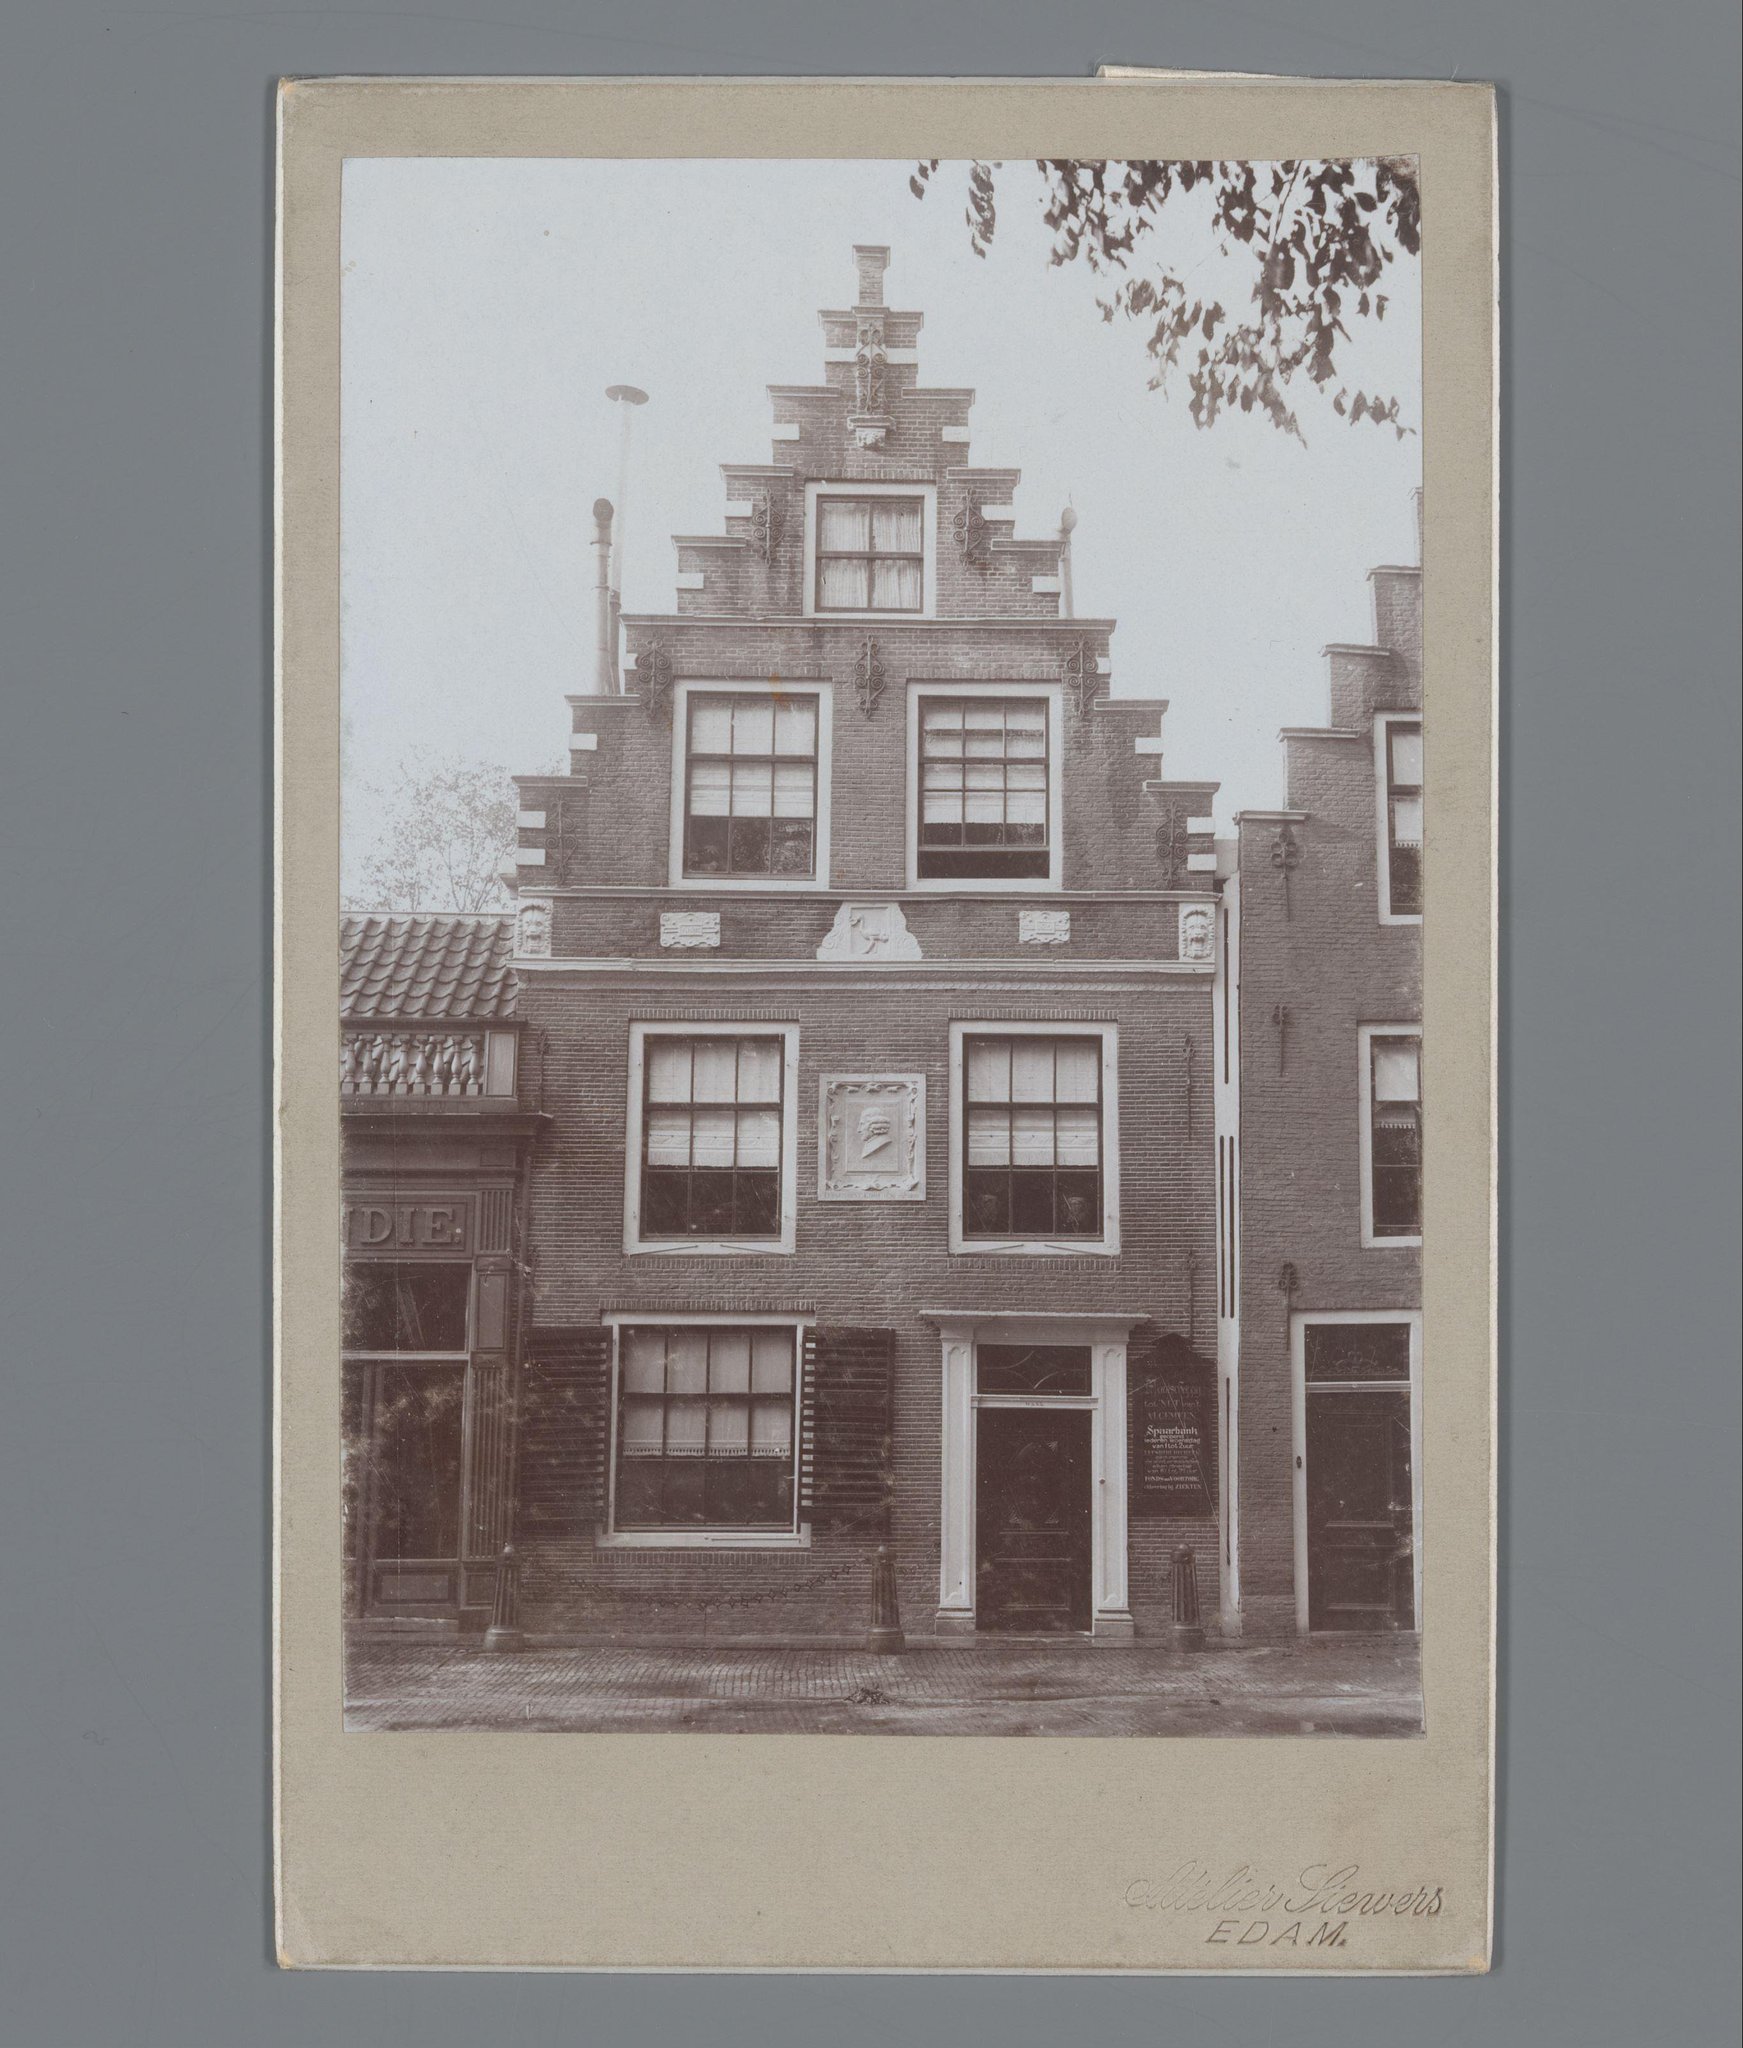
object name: photograph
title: Façade van de Maatschappij tot Nut van 't Algemeen te Edam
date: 1880-1910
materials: cardboard, photographic support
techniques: collodion silver print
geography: edam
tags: civic architecture; edifices; dwellings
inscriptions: inscription: ‘Atelier Siewers/ Edam’, number: ‘11683’, annotation: ‘Nut v h algemeen/ Edam’